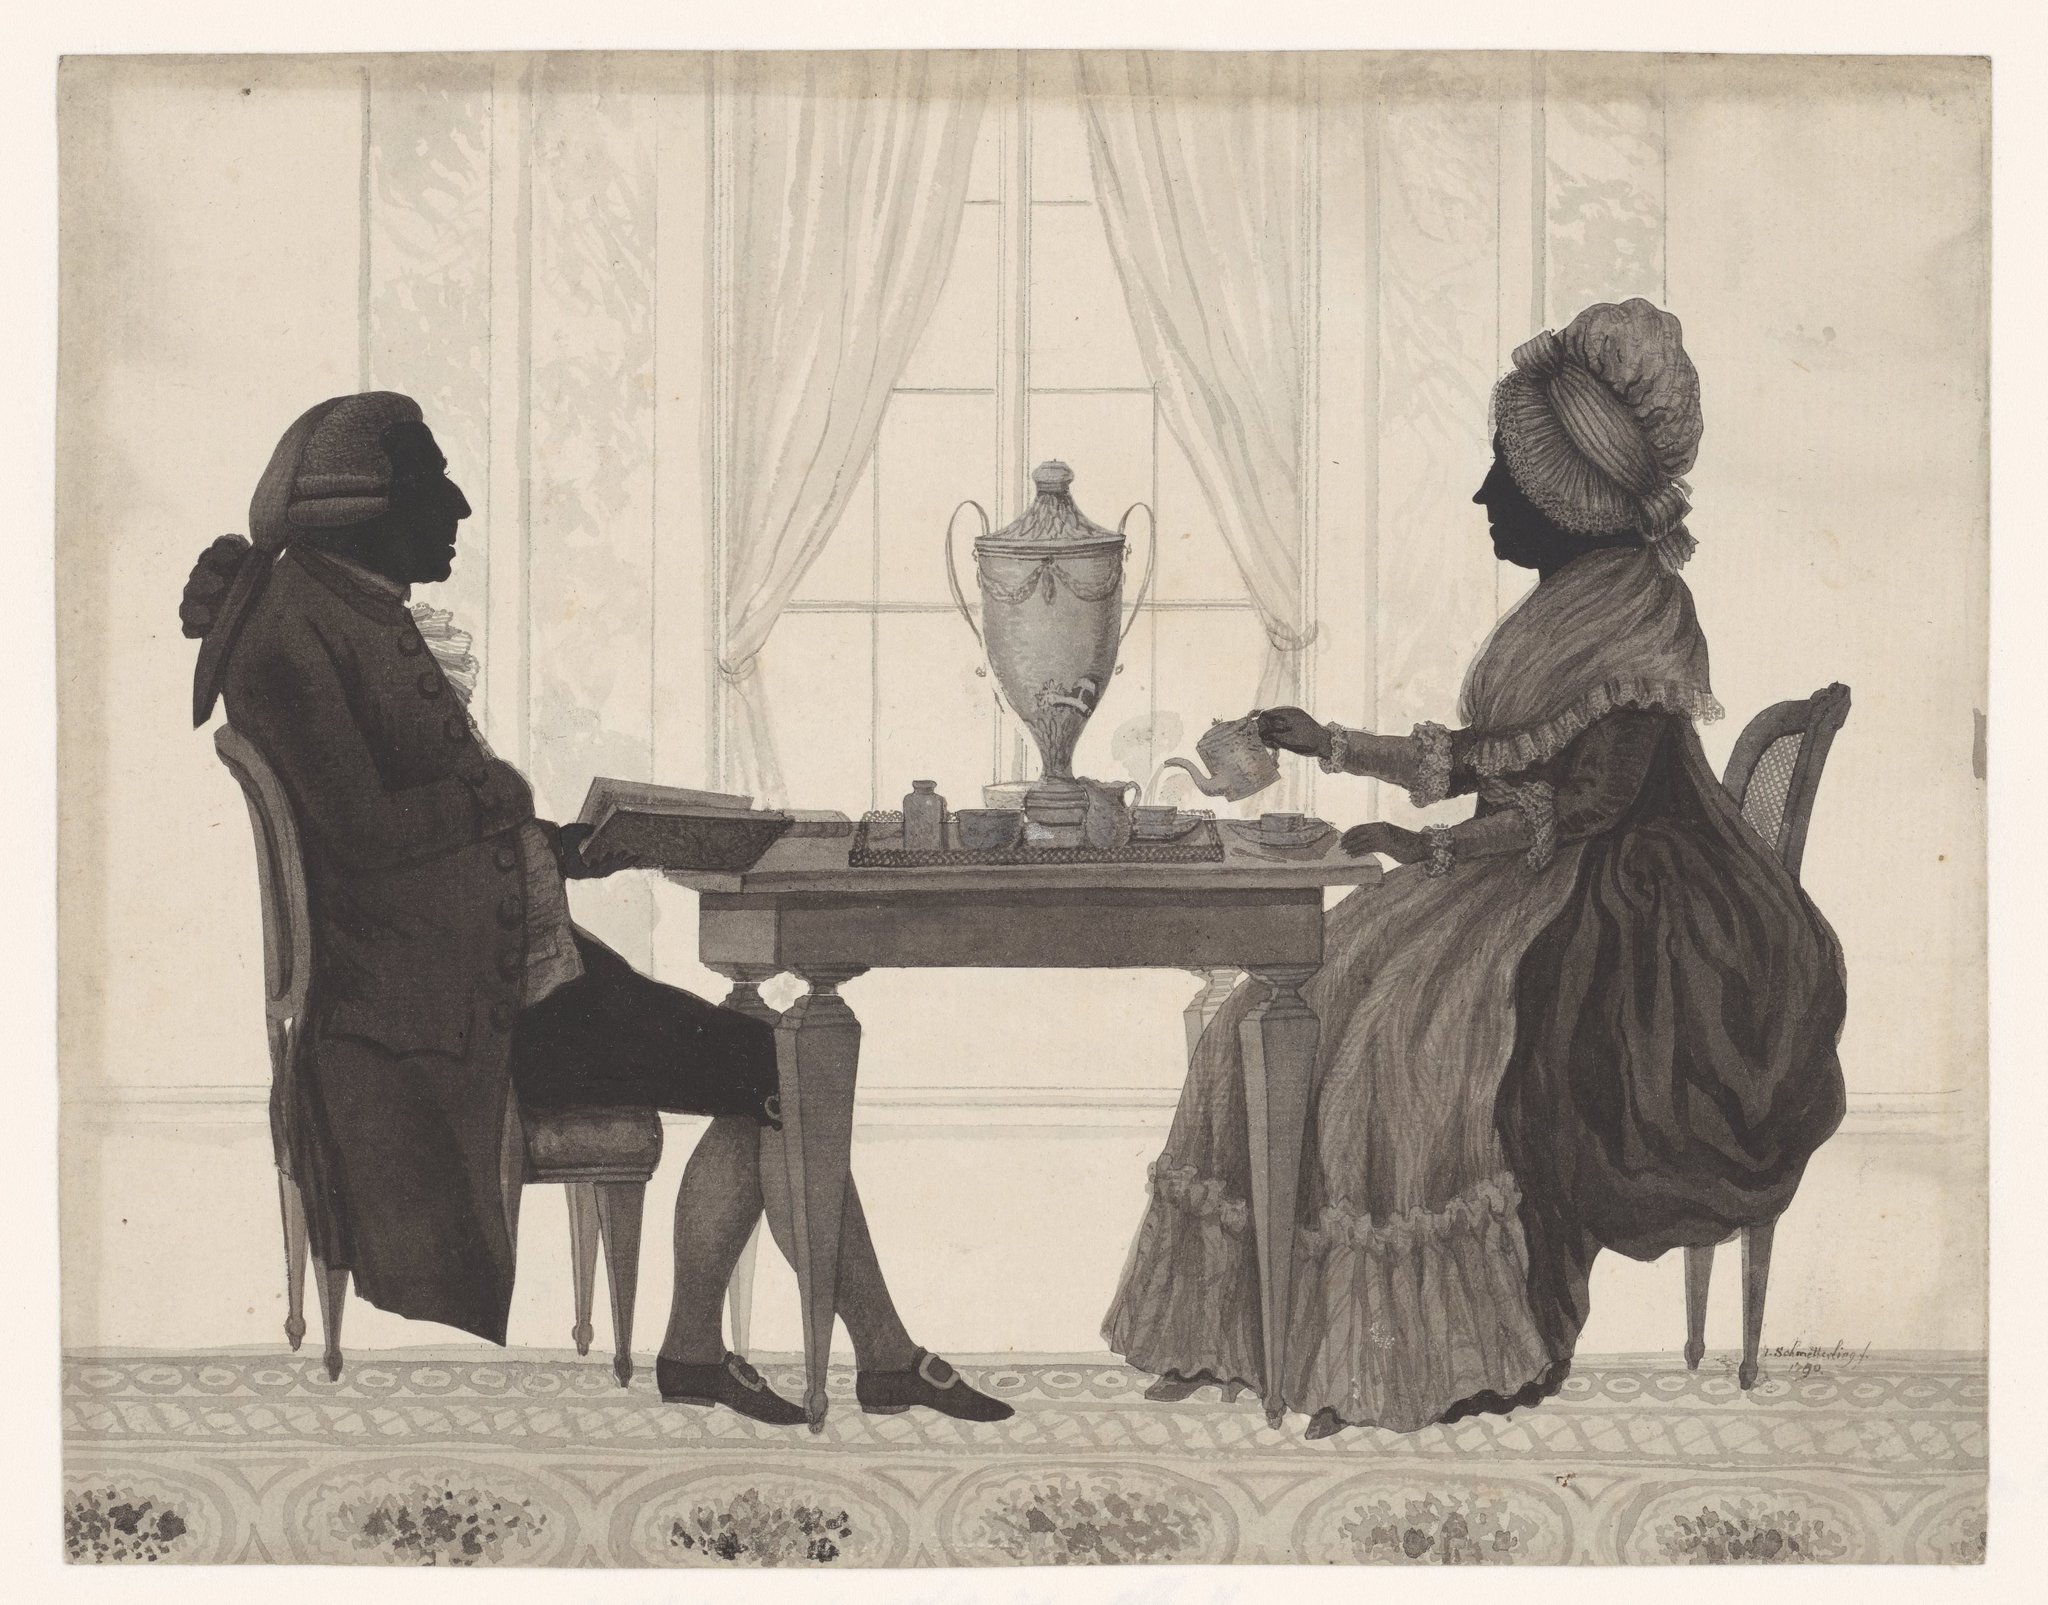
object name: drawing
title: Louis Metayer en Antoinette Bernard aan tafel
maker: joseph adolf schmetterling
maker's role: draughtsman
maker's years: 1751-1828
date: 1790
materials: paper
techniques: brush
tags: louis metayer phzn., antoinette bernard, historical persons - bb - woman, historical persons, morning coffee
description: De silhouetten van het echtpaar zijn uitgeknipt en opgeplakt. De tekening is vervolgens met penseel verder uitgewerkt. De uit Wenen afkomstige Schmetterling had zich in Amsterdam gevestigd en was daar portrettist van miniaturen en silhouetten geworden. Volgens de 'Physiognomie' van Lavater kan in silhouetten het best het karakter van mensen worden herkend.